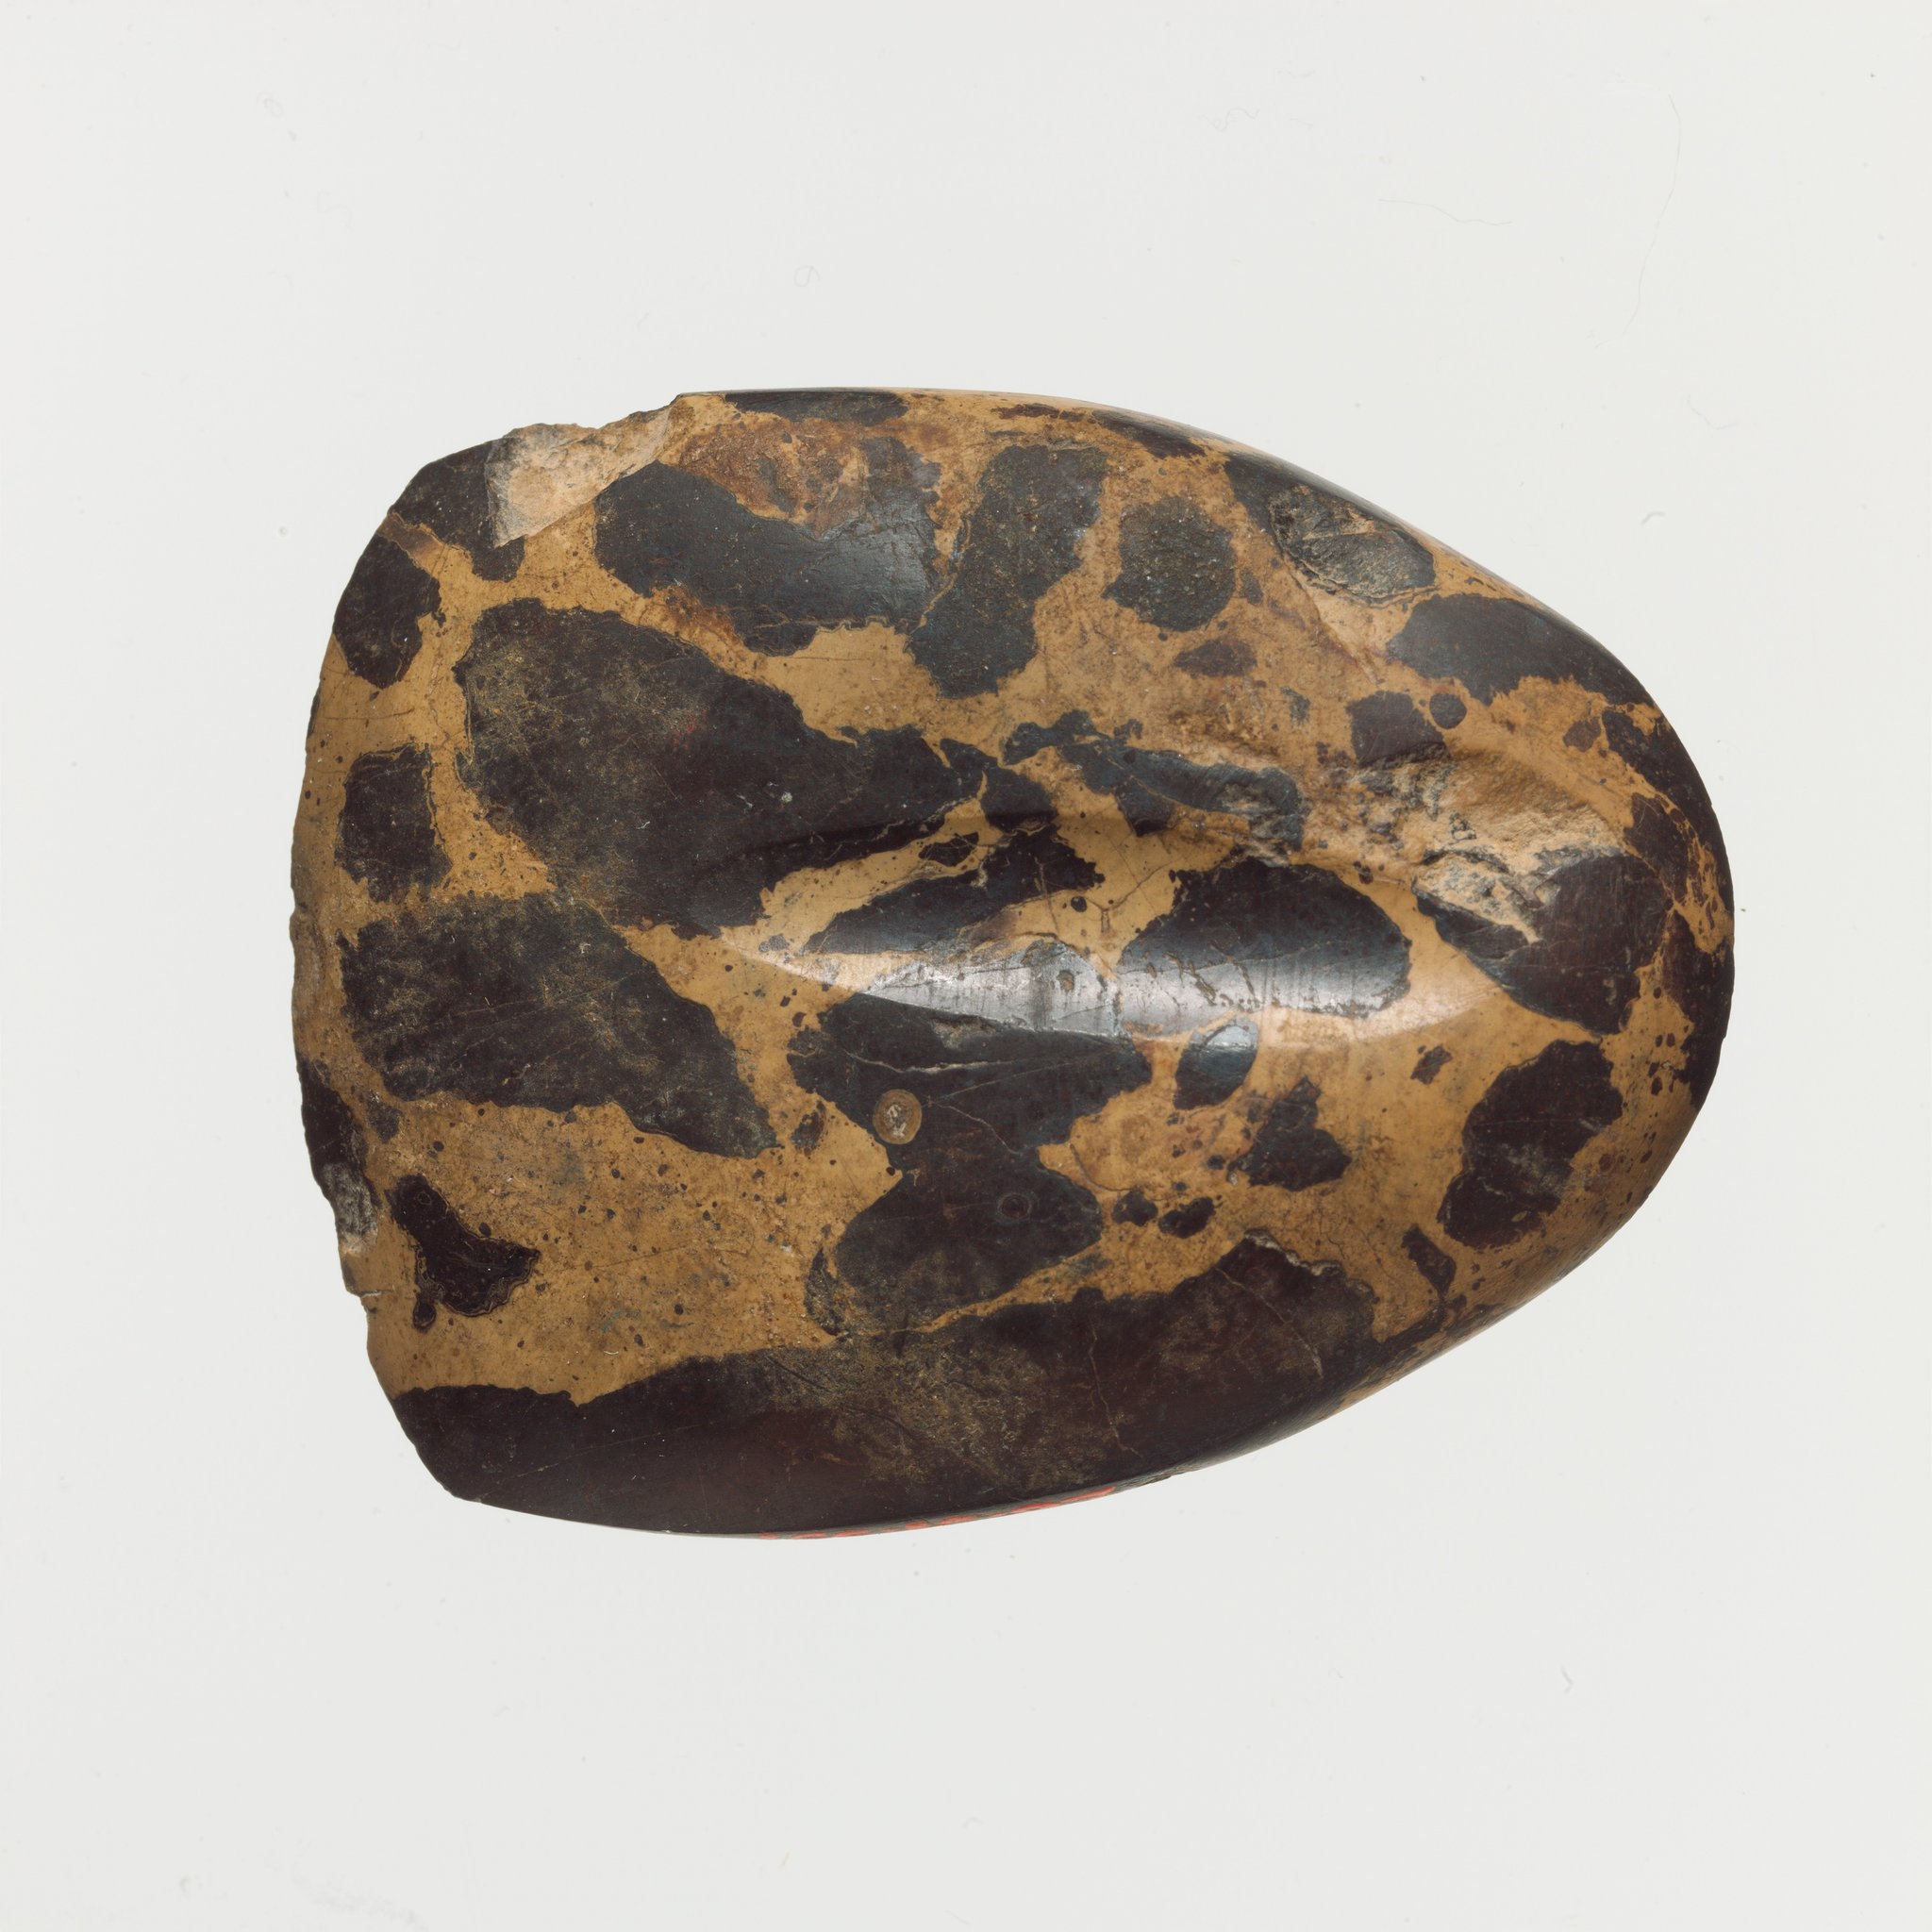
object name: celt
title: Metabauxite axe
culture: cretan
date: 5000-3001 BCE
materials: stone